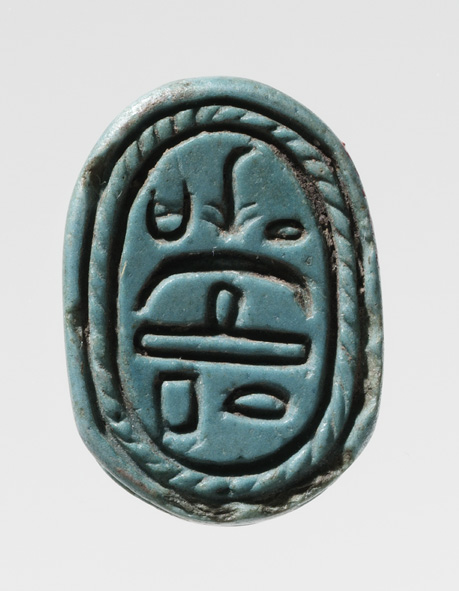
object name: scarab, queen ahhotep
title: Scarab Inscribed With the Name of Queen Ahhotep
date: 1560-1458 BCE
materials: faience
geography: egypt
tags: hieroglyphs,scarabs